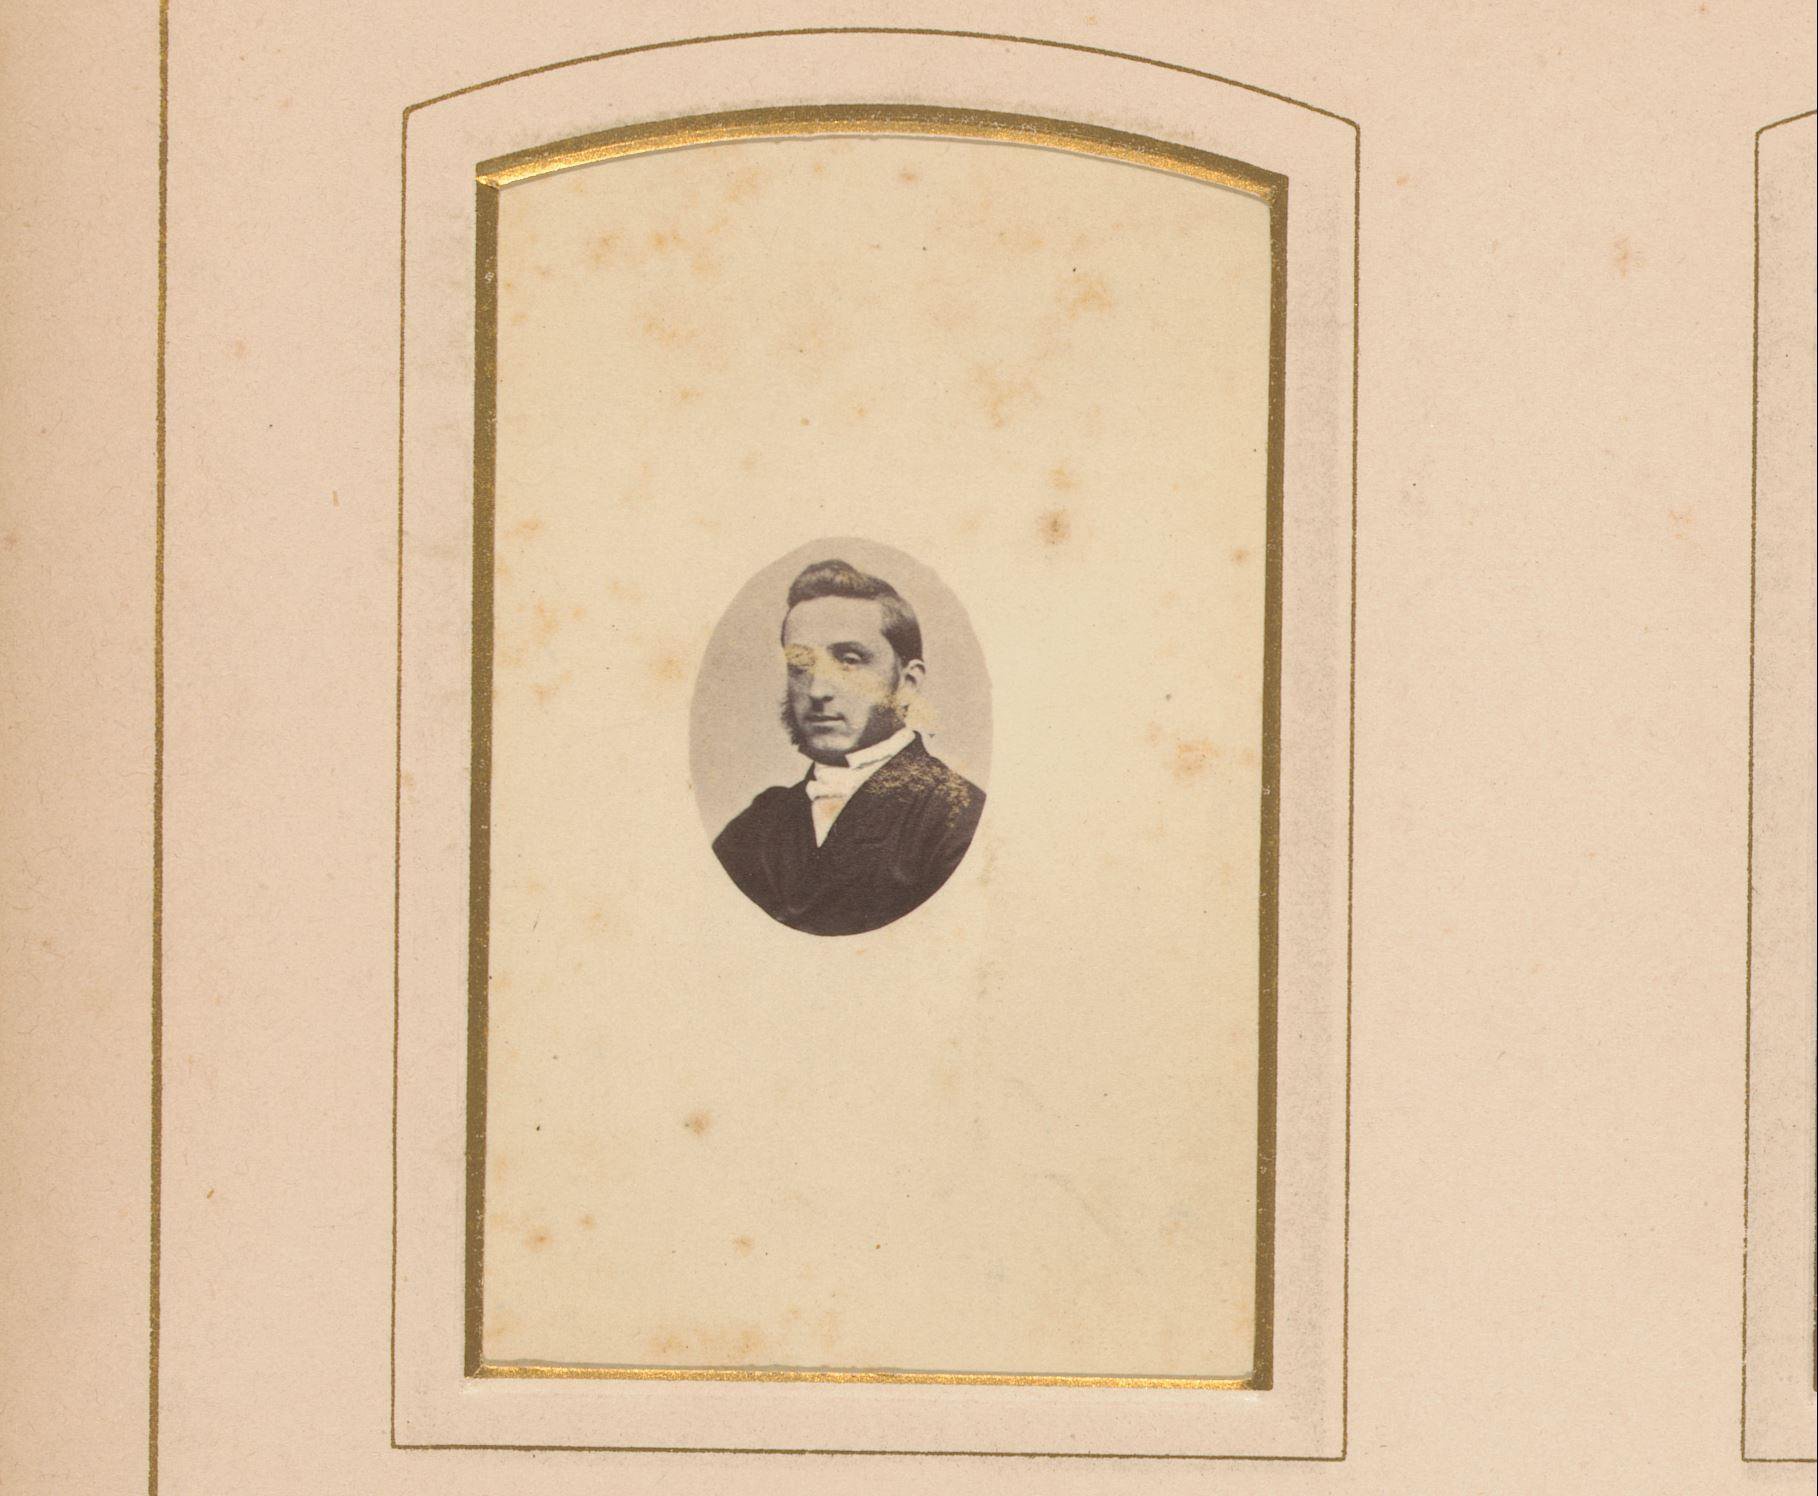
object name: album leaf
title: Portret van een man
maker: willem cornelis van dijk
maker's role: painter, print maker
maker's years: 1826-1881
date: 1863-1871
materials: cardboard, photographic support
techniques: albumen print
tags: historical persons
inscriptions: inscription: ‘W. C. van Dijk/ PHOTOGRAPHE/ UTRECHT/ Langenieuwstraat/ Lett. A. No. 522.’